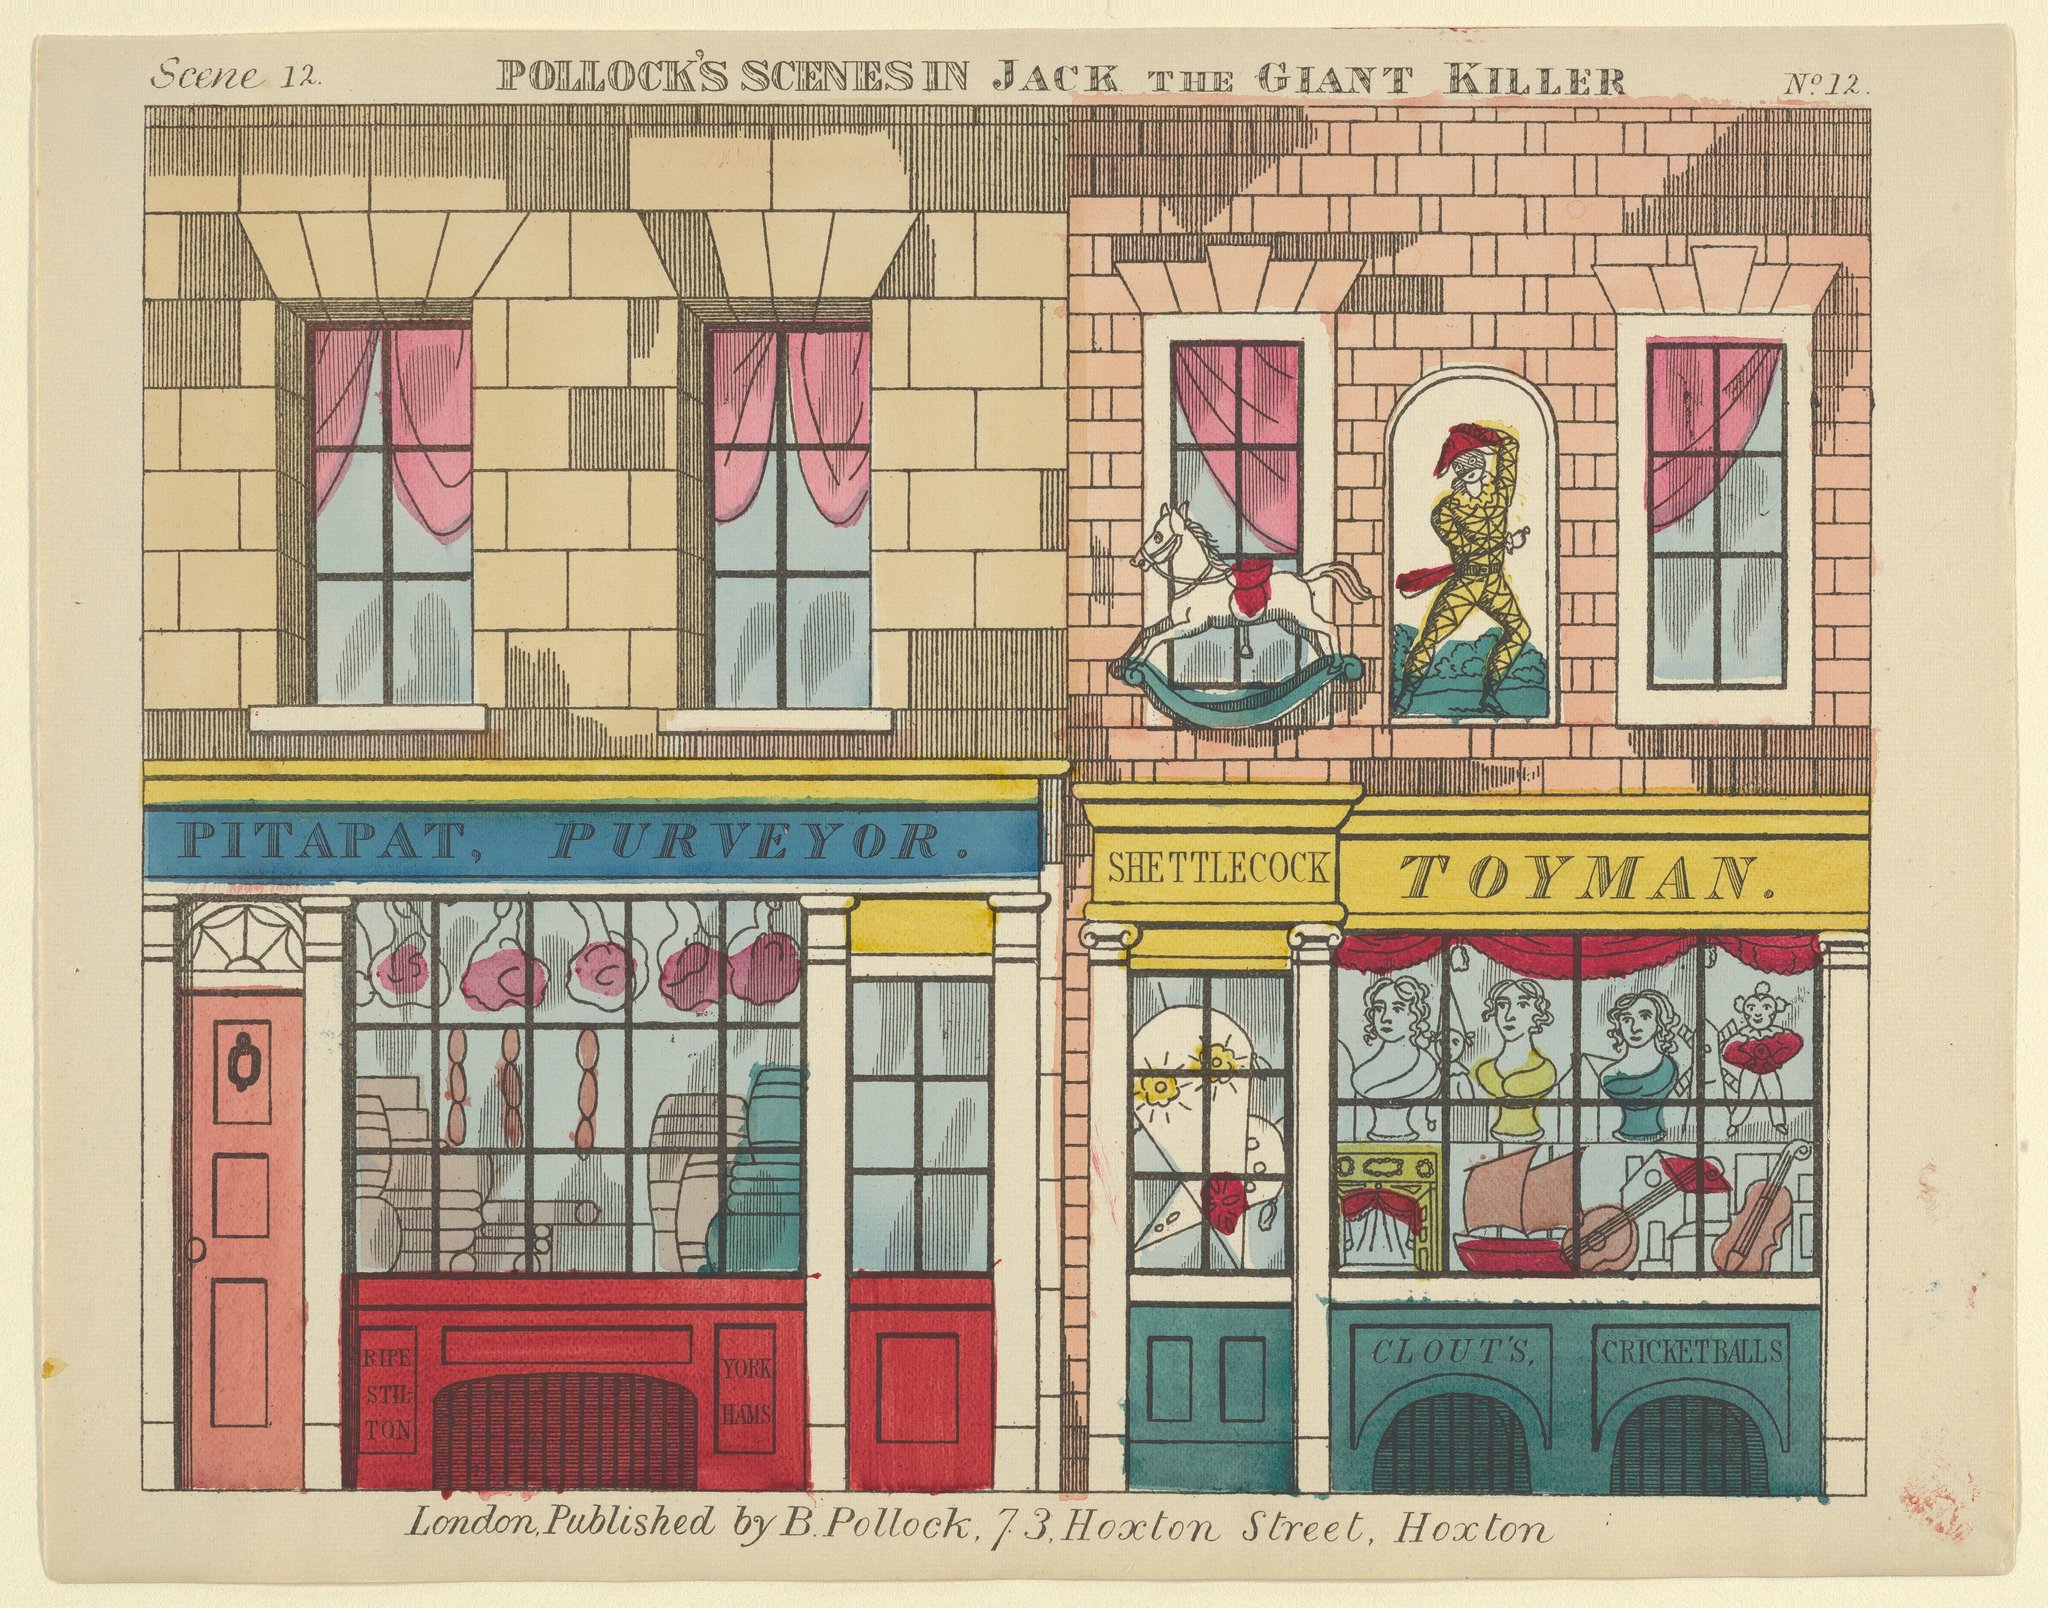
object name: print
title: Scene 12, from Jack and the Giant Killer, Scenes for a Toy Theater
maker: benjamin pollock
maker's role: publisher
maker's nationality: british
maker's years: 1857-1937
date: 1870-1890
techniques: lithograph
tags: theatre